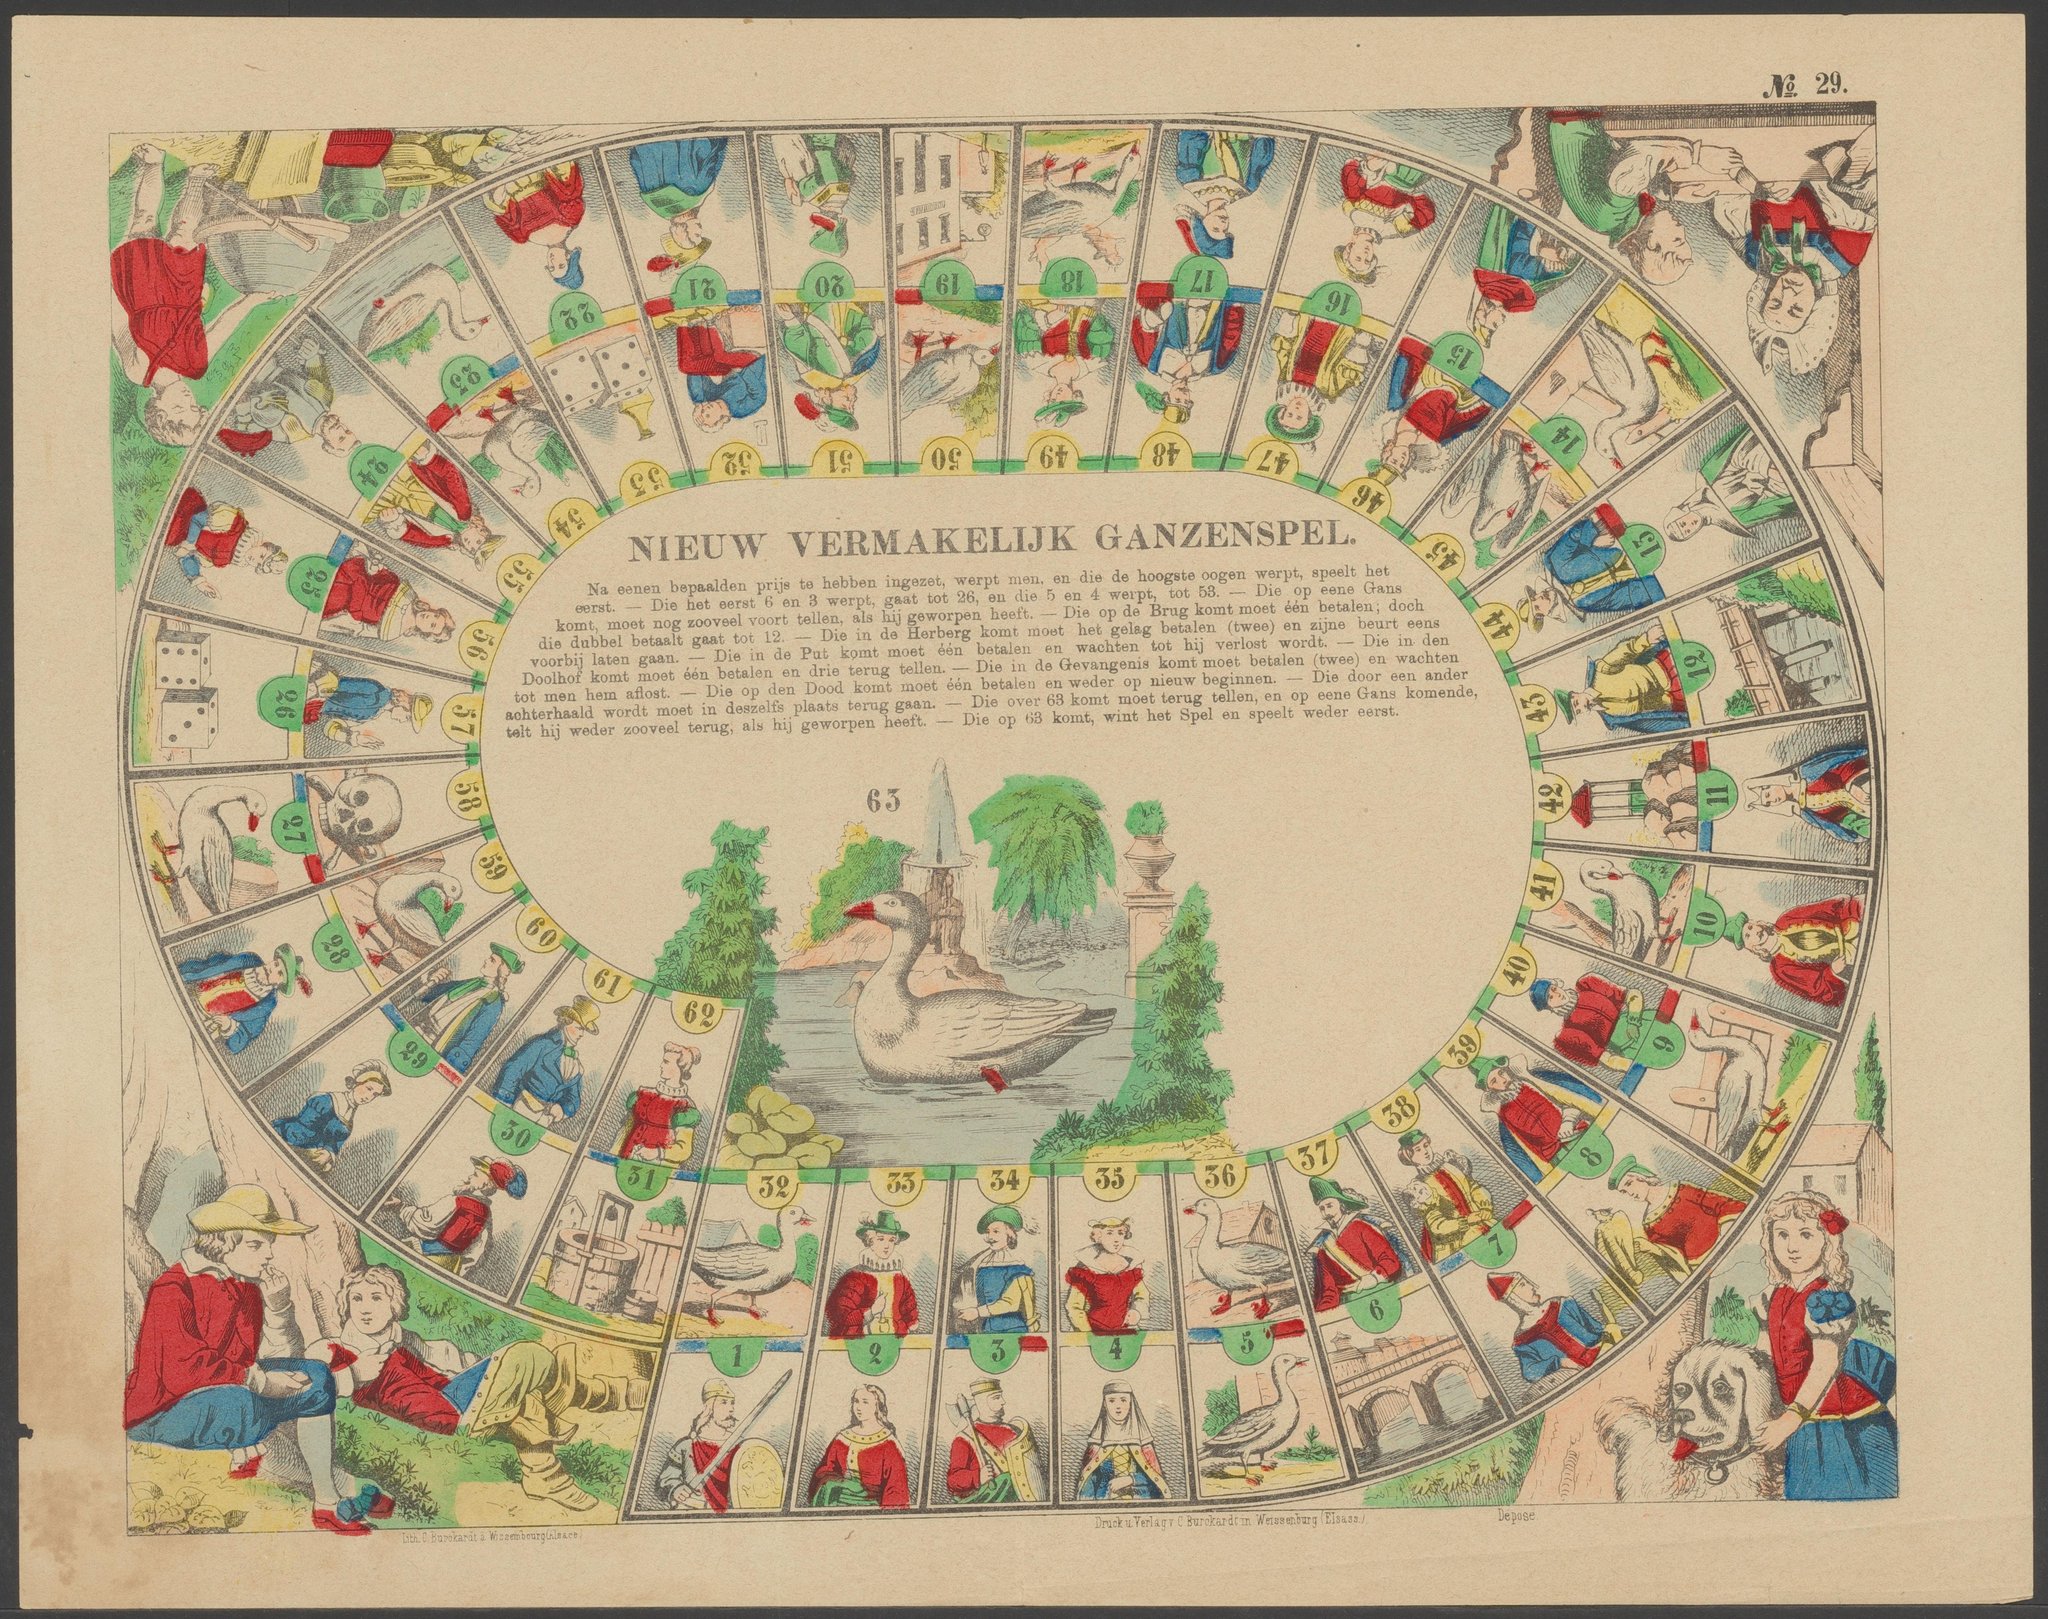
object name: gameboard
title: Speelbord voor het vermakelijke ganzenspel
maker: camille burckardt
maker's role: printer, publisher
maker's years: -1888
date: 1870-1889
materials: paper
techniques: hand coloring, letterpress printing, lithograph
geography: weissenburg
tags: goose-game, board-games of chance, board-games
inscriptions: : ‘Déposé’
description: Ovaal met genummerde vakken van 1 tot 63. Elk vak toont een afbeelding van een persoon, een gans, een bouwwerk of dobbelstenen. In het midden een zwemmende gans bij een fontein en de spelregels. In de vier hoeken rondom de ovaal twee jongens in een bos, een meisje met een hond, een lezende jongen met een oudere vrouw aan een tafel en een kind met onder andere een verrekijker. De figuren in historische kleding. Genummerd rechtsboven: No. 29. Onderwerpsrubrieken binnen de Atlas Zeden en Gewoonten: Zeden en gewoonten in engeren zin, Spel en vermaak, Gezelschapsspel II, Ganzenbord en dergelijke.